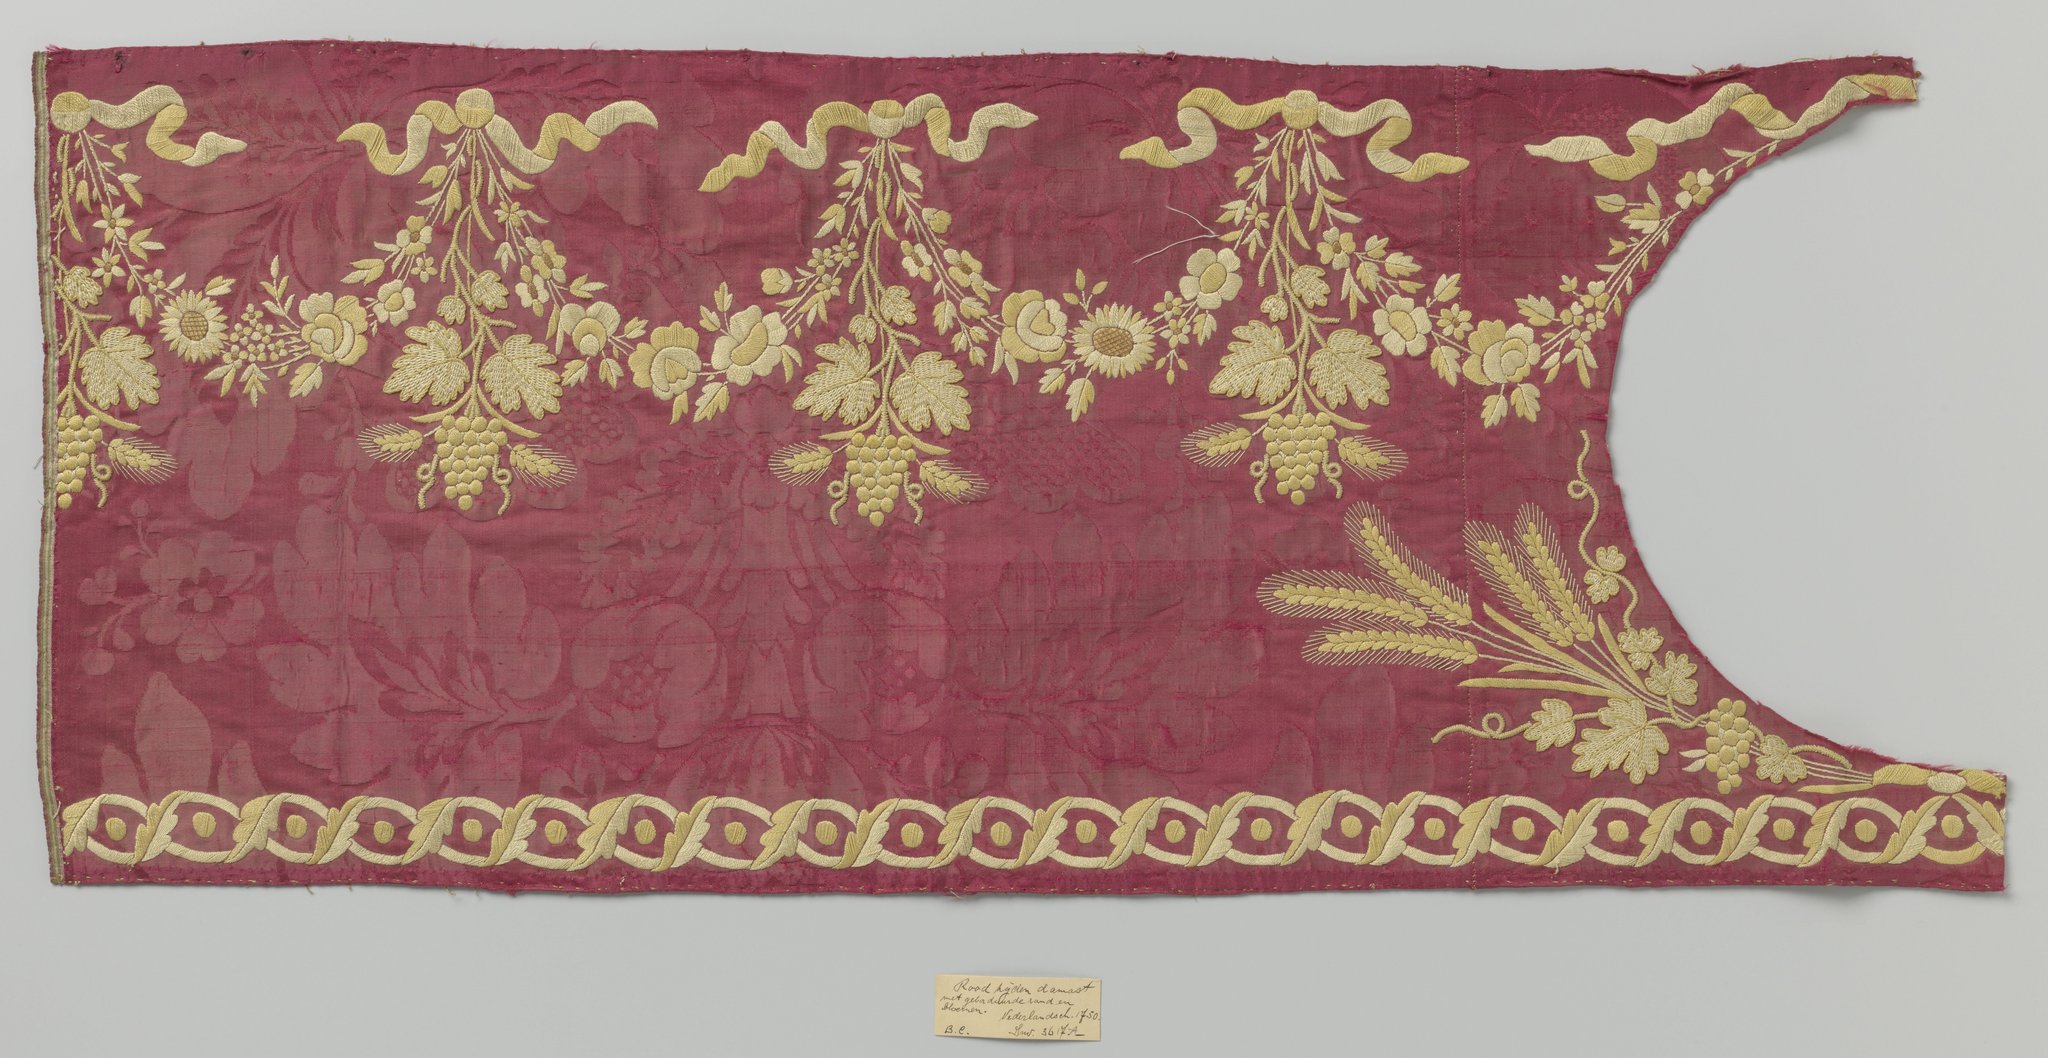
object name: zijdedamast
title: Fragment rood zijdeweefsel met borduurwerk in geel en lichtgroen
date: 1750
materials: linen, silk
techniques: damask, embroidered, weave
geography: netherlands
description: Fragment rood zijdeweefsel, damast, met borduurwerk. Het damast heeft een symmetrisch patroon van grote bloemen en bladeren. Langs een lange zijde is een ketting geborduurd en langs de andere lange zijde een guirlande waaruit druivenranken ontspringen. Een korte zijde is rond ingeknipt en heeft langs de ronding een korenaren met een wijnrank lopen. Het fragment bestaat uit twee aaneengenaaide fragmenten.